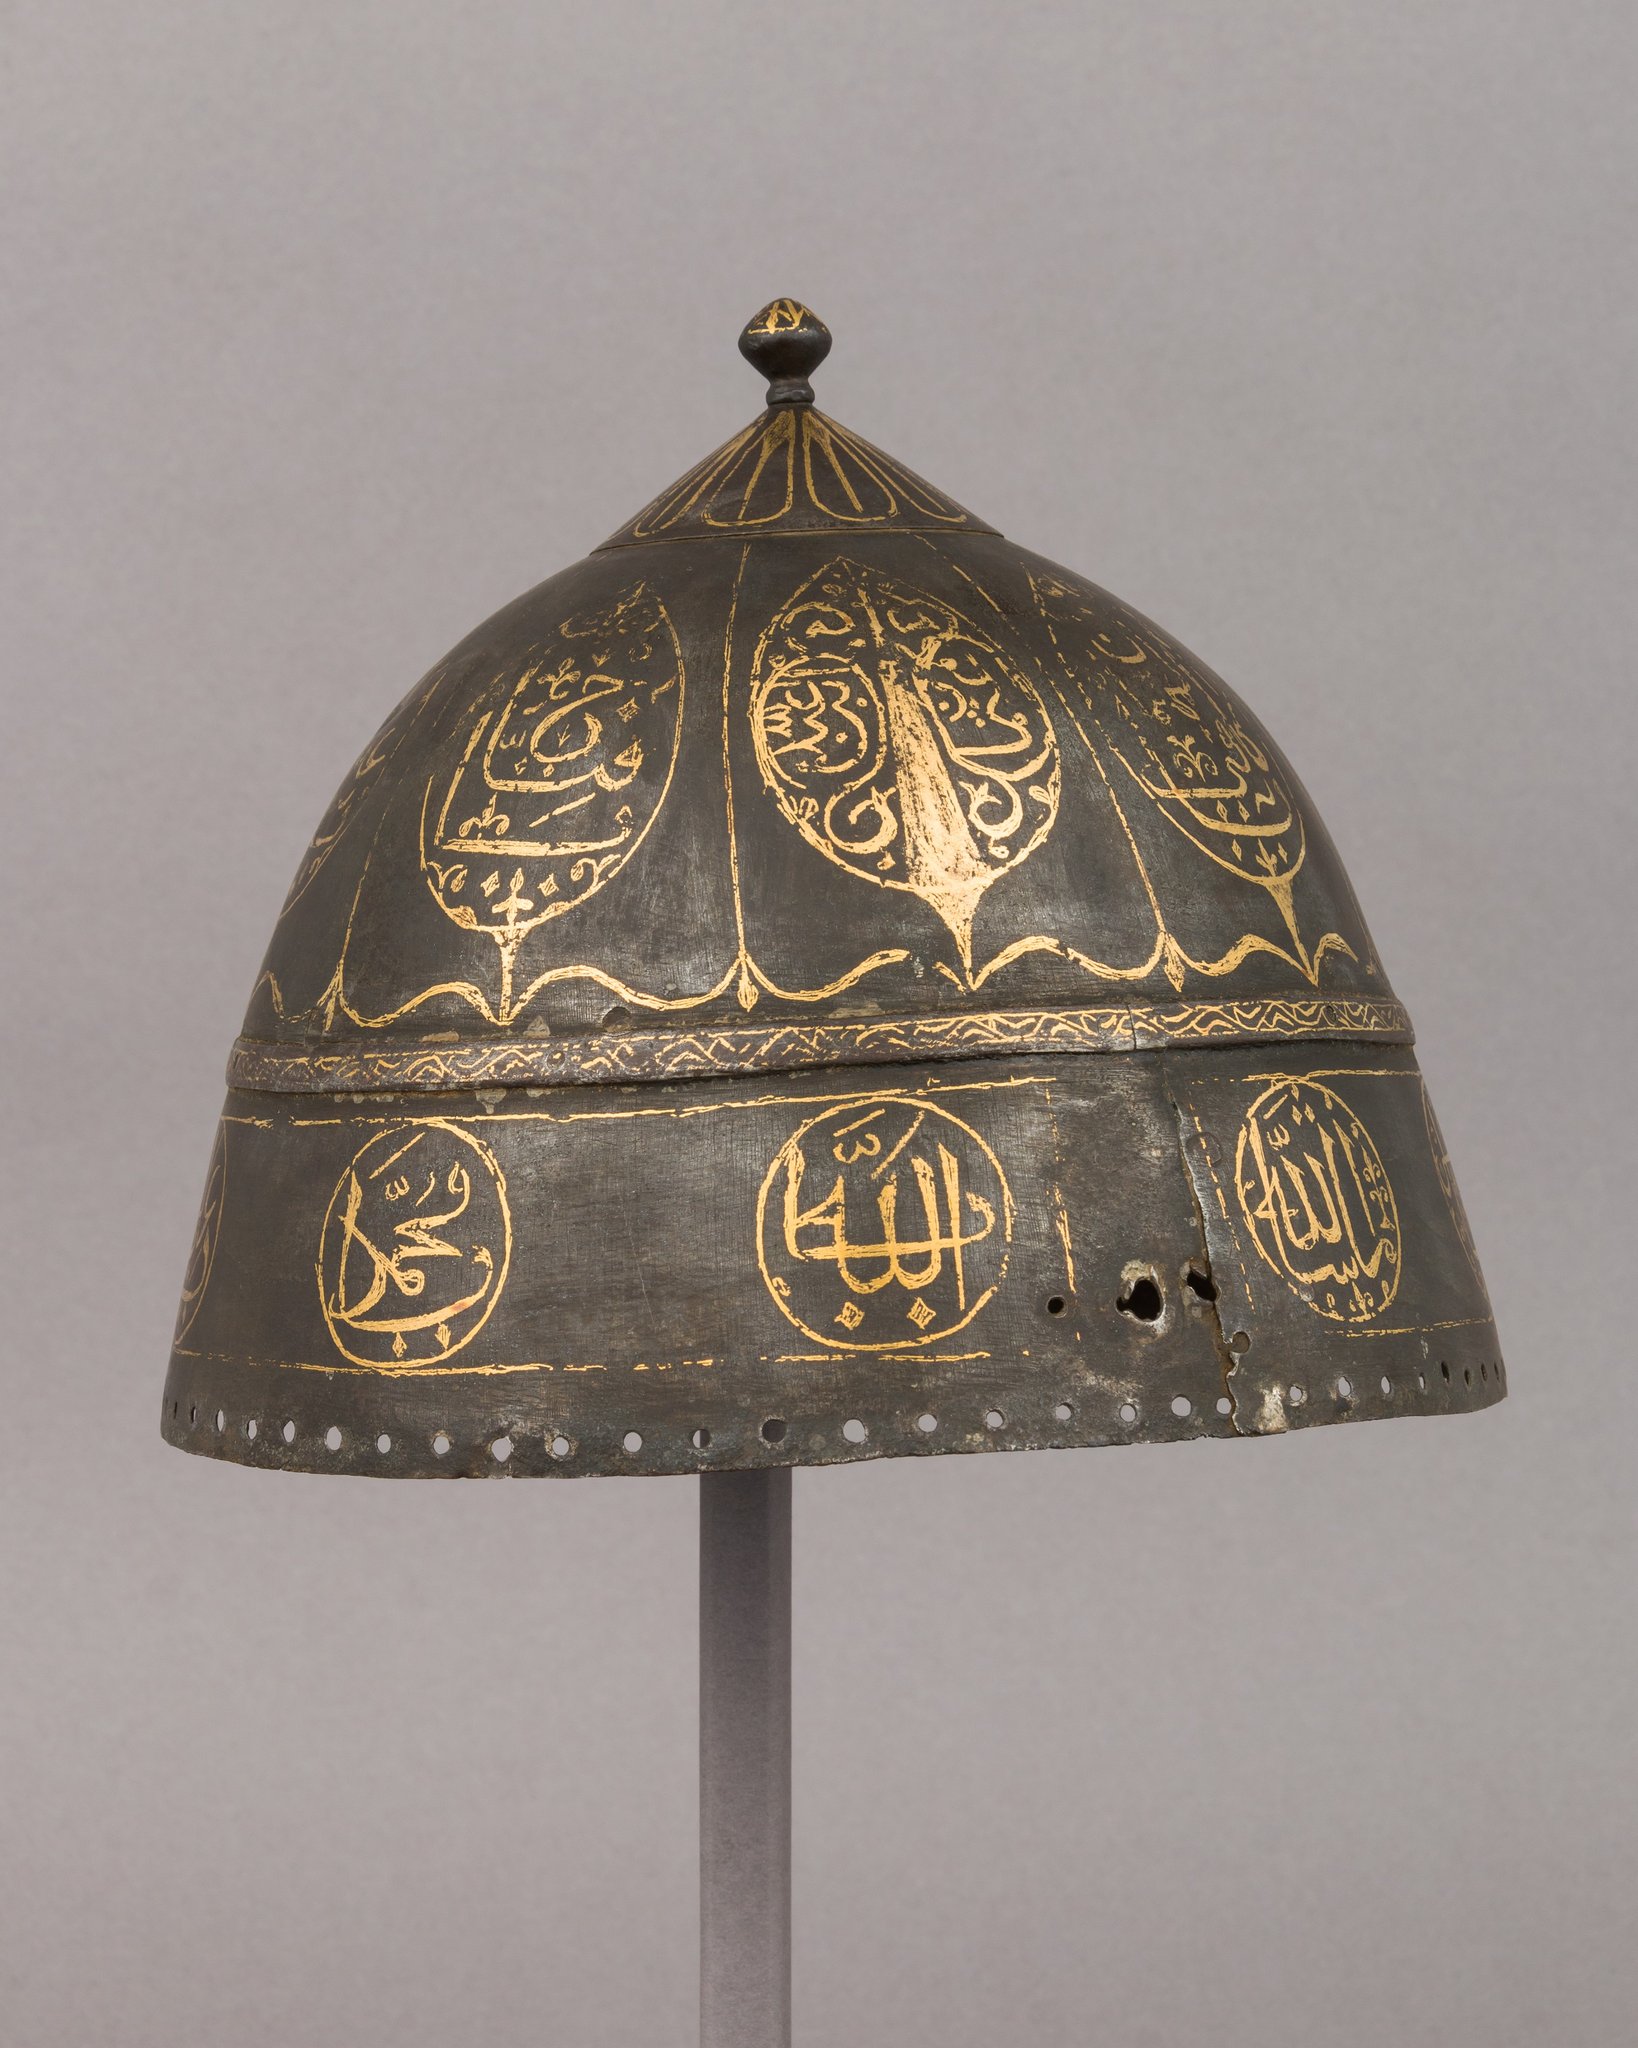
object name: helmet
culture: egyptian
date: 1734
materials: gold, steel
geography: egypt